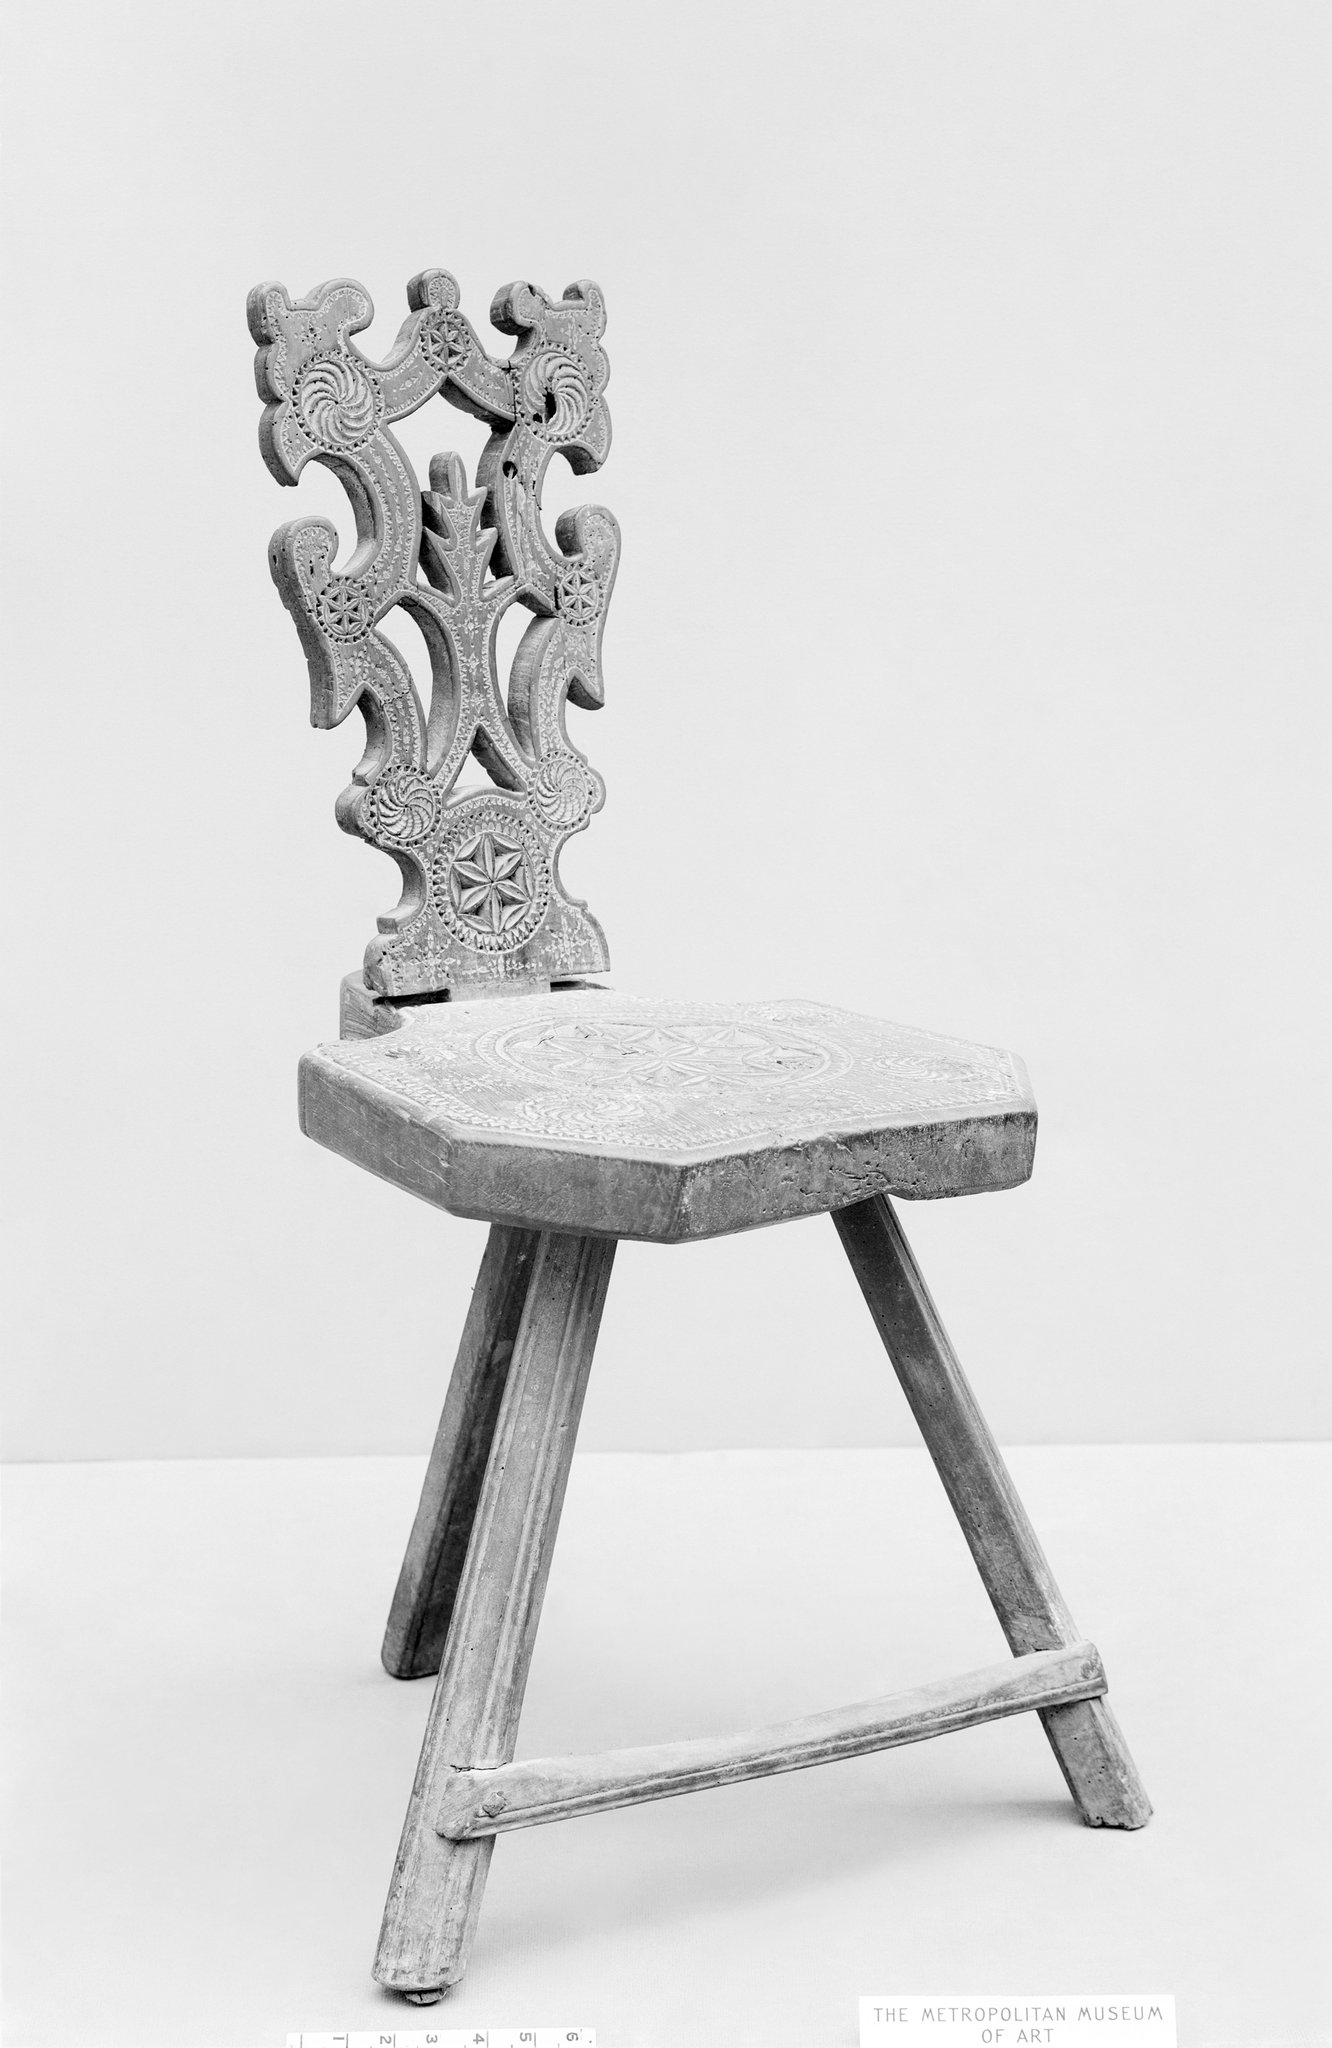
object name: chair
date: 1601-1700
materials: wood